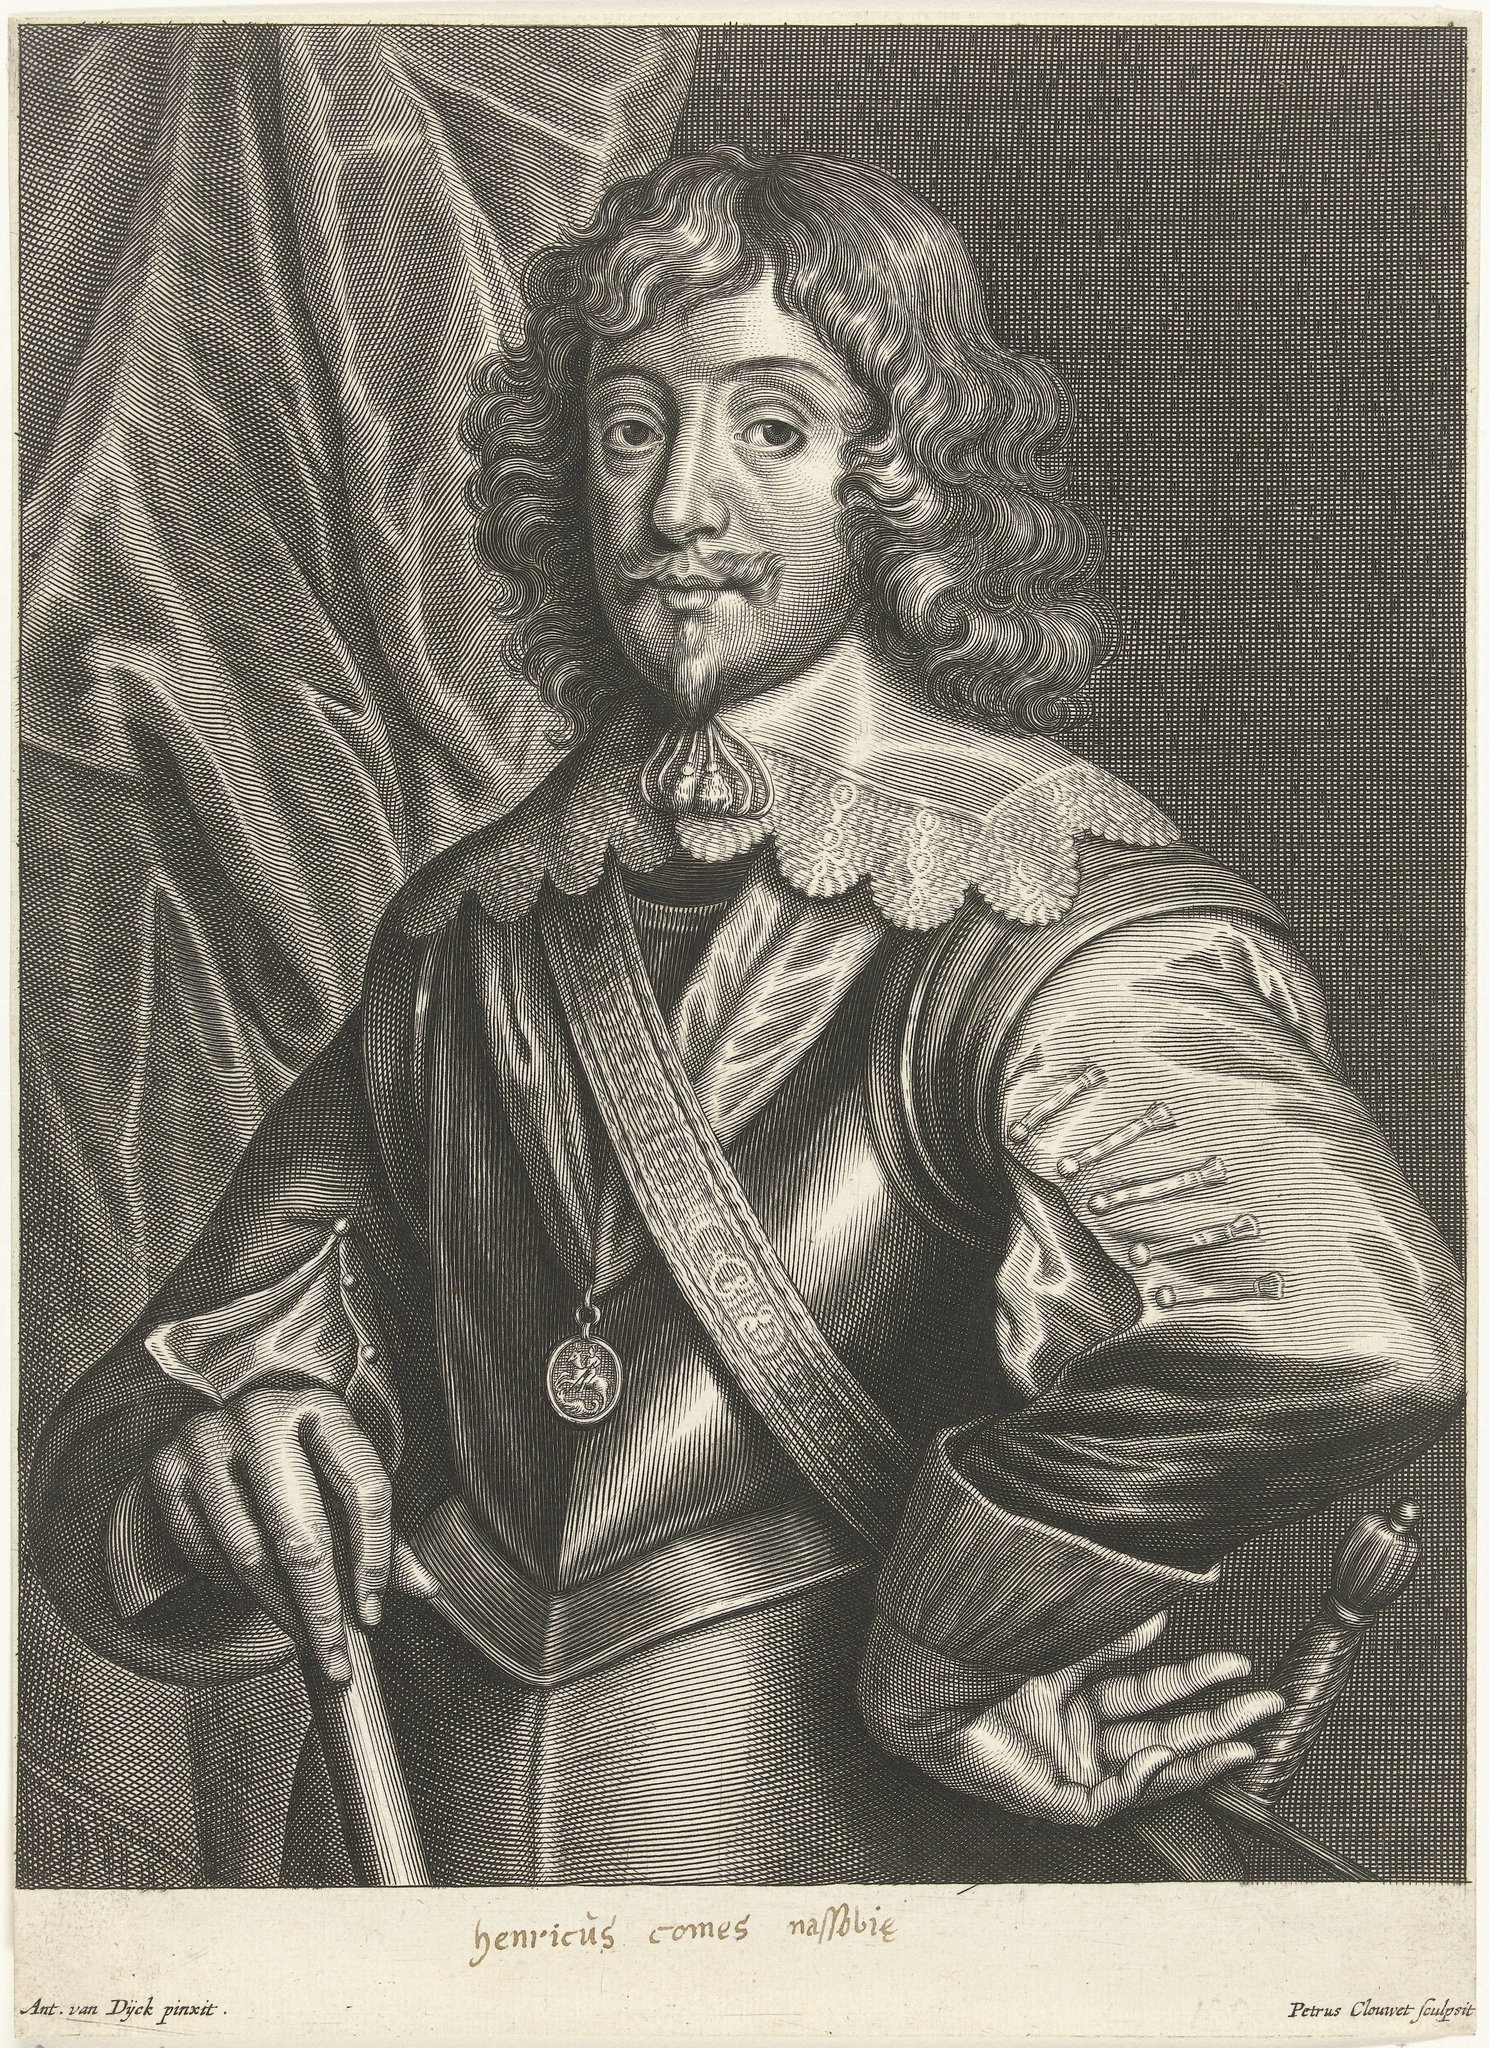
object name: print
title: Portret van Hendrik Rich, graaf van Holland en Warwick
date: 1639-1670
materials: paper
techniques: engraving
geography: antwerp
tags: hendrik rich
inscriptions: collector's mark: Lugt 240, caption: ‘henricus comes nambie’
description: Portret van Hendrik Riche, graaf van Holland en Warwick. Buste naar links.